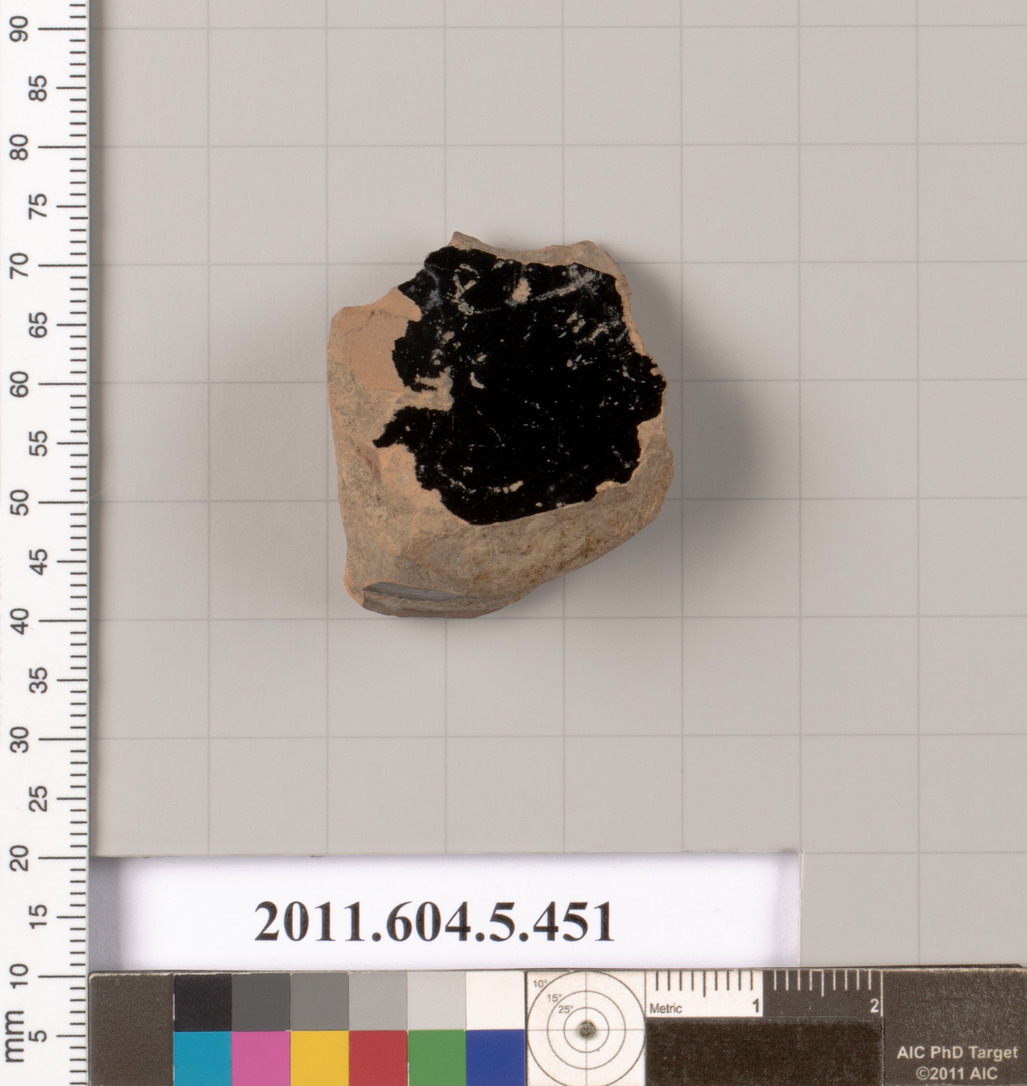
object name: kylix fragment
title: Terracotta fragment of a kylix (drinking cup)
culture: greek, attic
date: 600-401 BCE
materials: terracotta